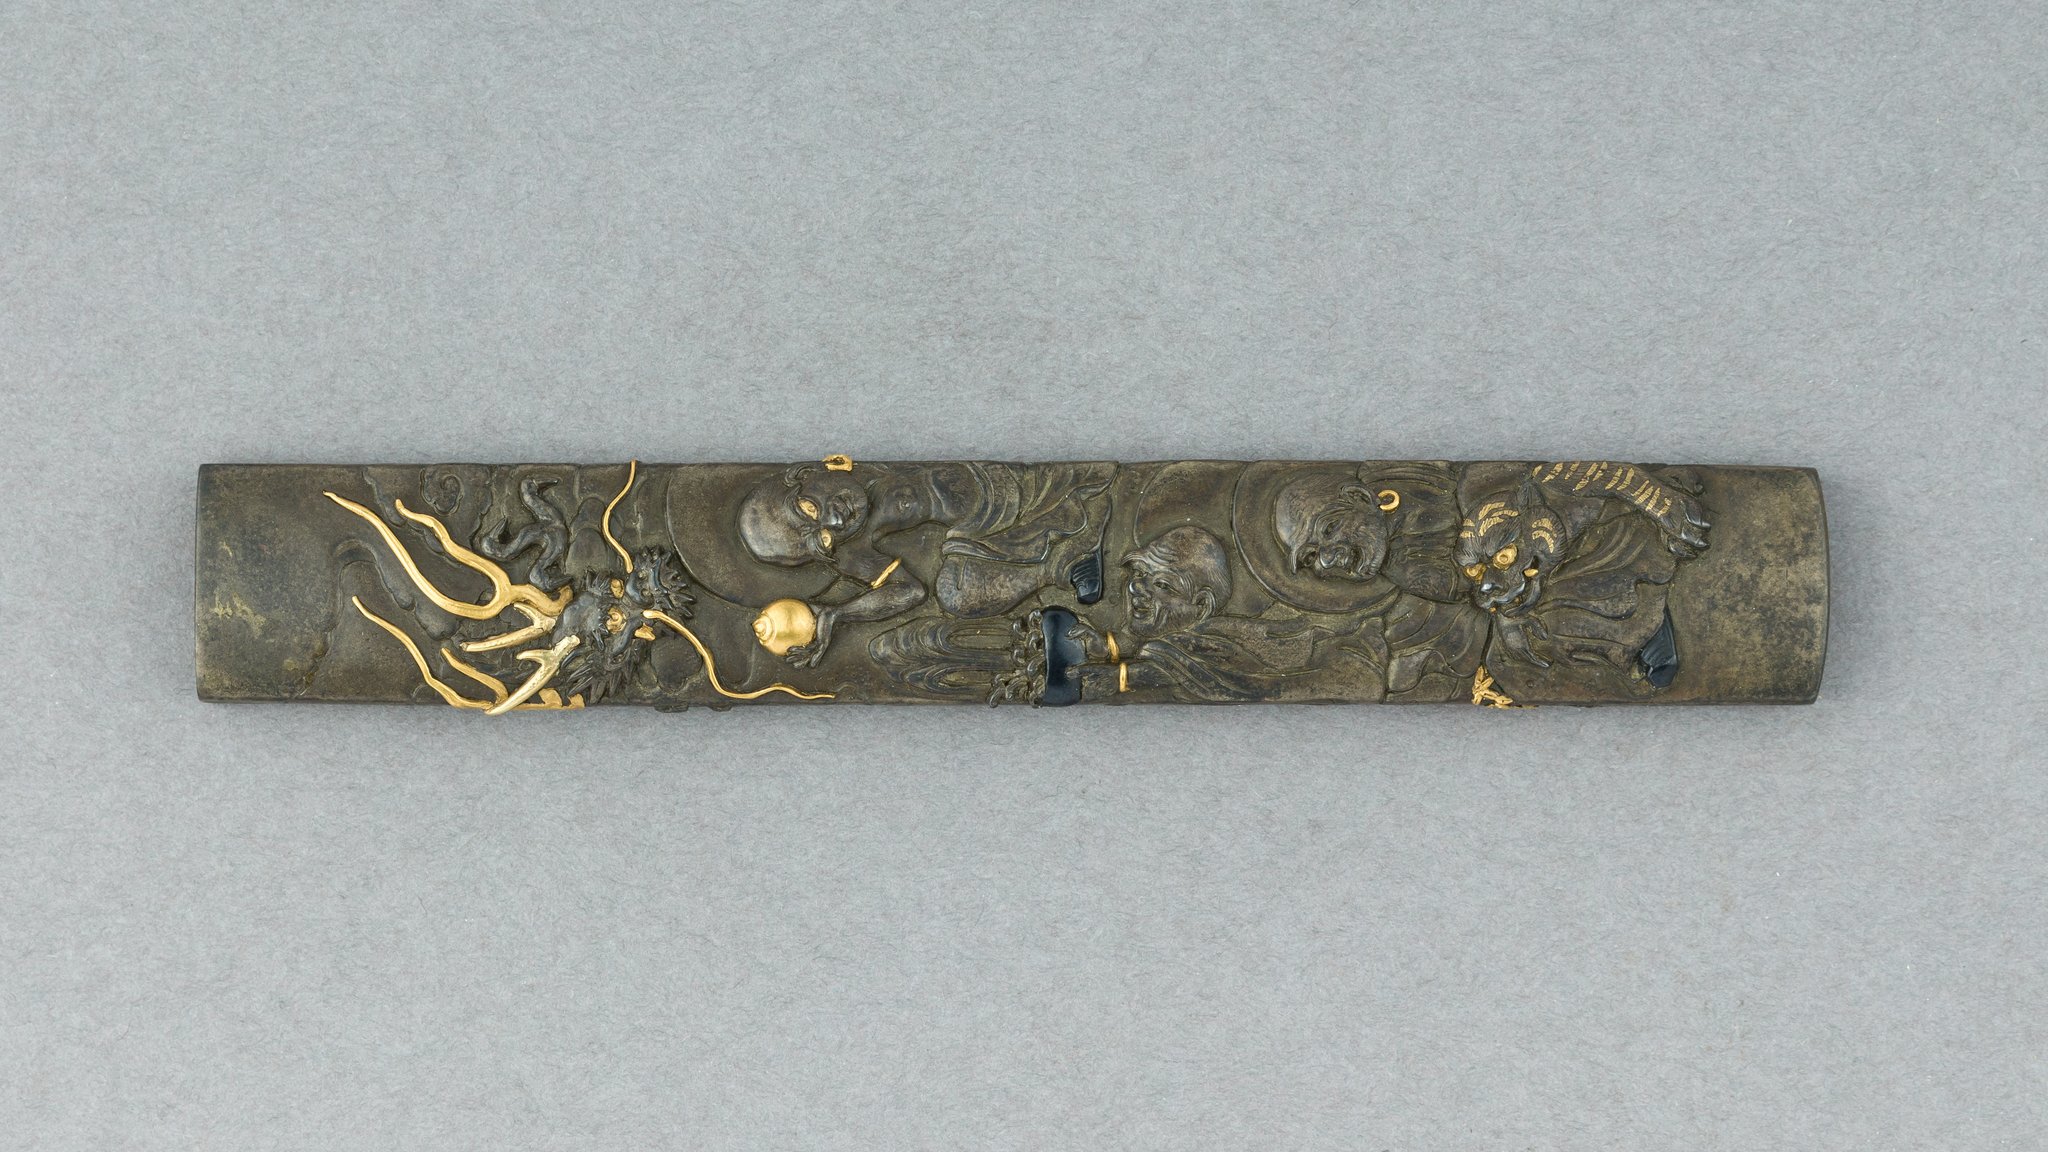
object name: knife handle kozuka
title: Knife Handle (Kozuka)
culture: japanese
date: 1615-1868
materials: copper, gold alloy, silver alloy, gold, silver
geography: japan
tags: animals,men,dragons